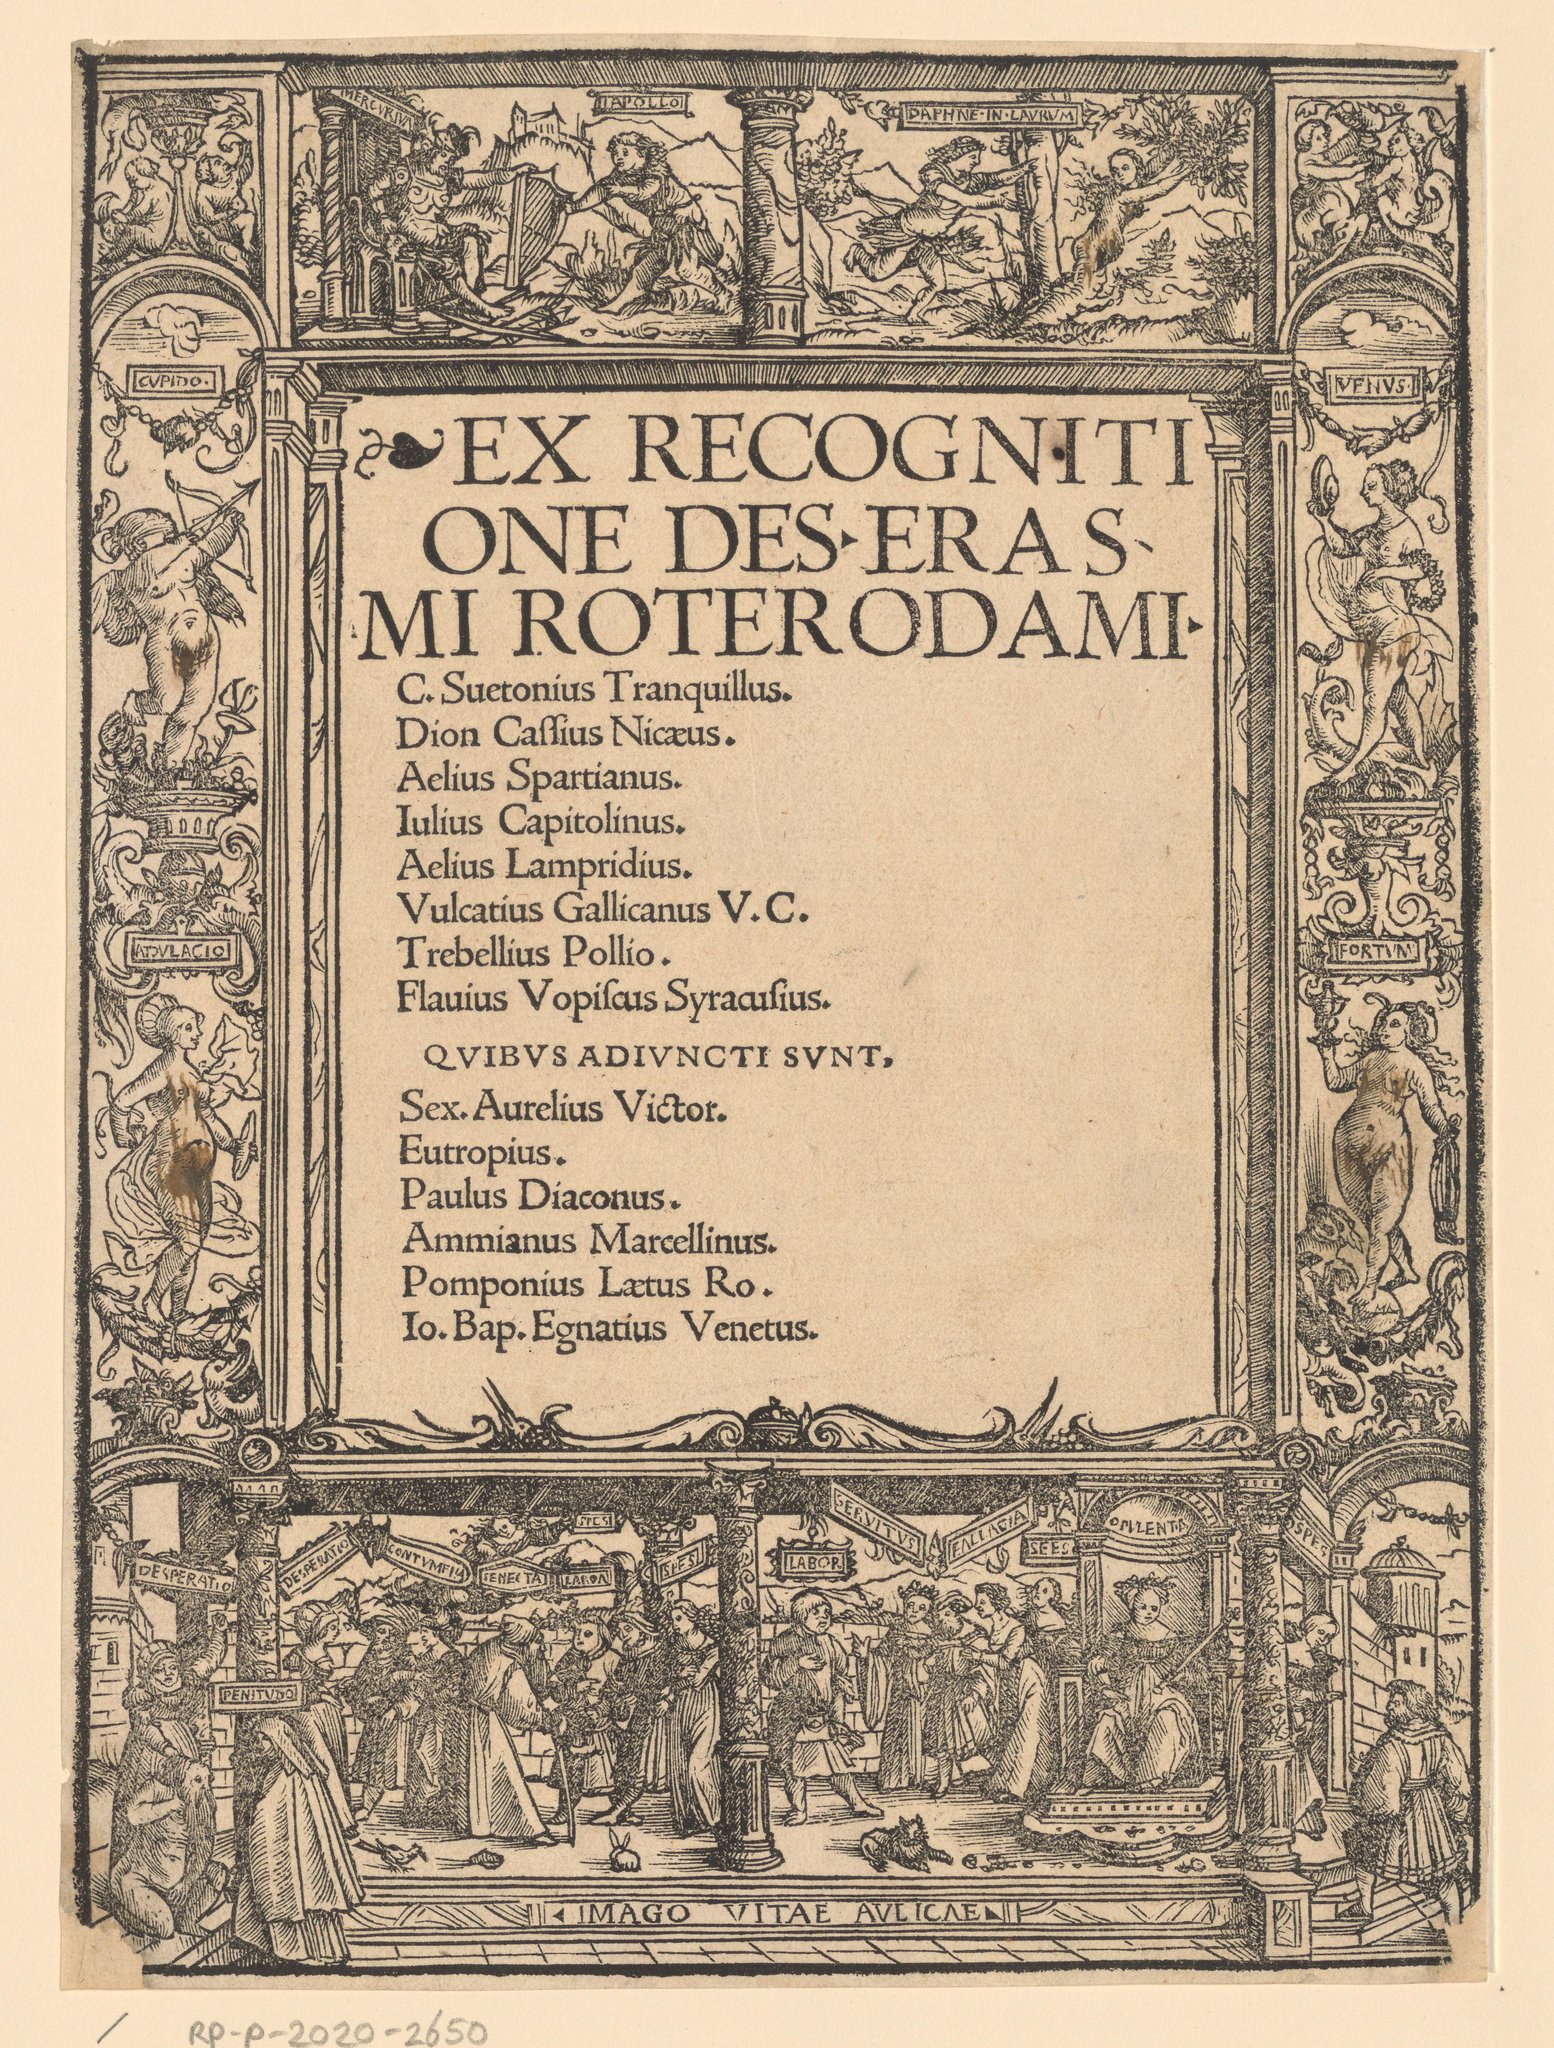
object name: print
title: Titelpagina voor: Desiderius Erasmus, Ex Recognitione Des. Erasmi Roterodami (...), 1518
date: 1520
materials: paper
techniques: letterpress printing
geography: basel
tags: opulentia (opulence) as roman personification, fortuna as roman personification, (story of) cupid, amor (eros), (story of) venus (aphrodite), mercury gives his lyre to apollo, daphne changed into a laurel-tree: while fleeing from apollo, daphne is changed into a laurel-tree by her father peneus (ovid, metamorphoses i 548)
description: Rondom de tekst een decoratieve omlijsting. Boven ontvangt Apollo de lier van Mercurius. Daarnaast de metamorfose van Daphne in een laurierboom. Links en rechts van de tekst staan Cupido en Venus. Beneden een scène aan een hof met verscheidene personificaties waarbij de personificatie van Opulentia (Rijkdom) op een troon zit.